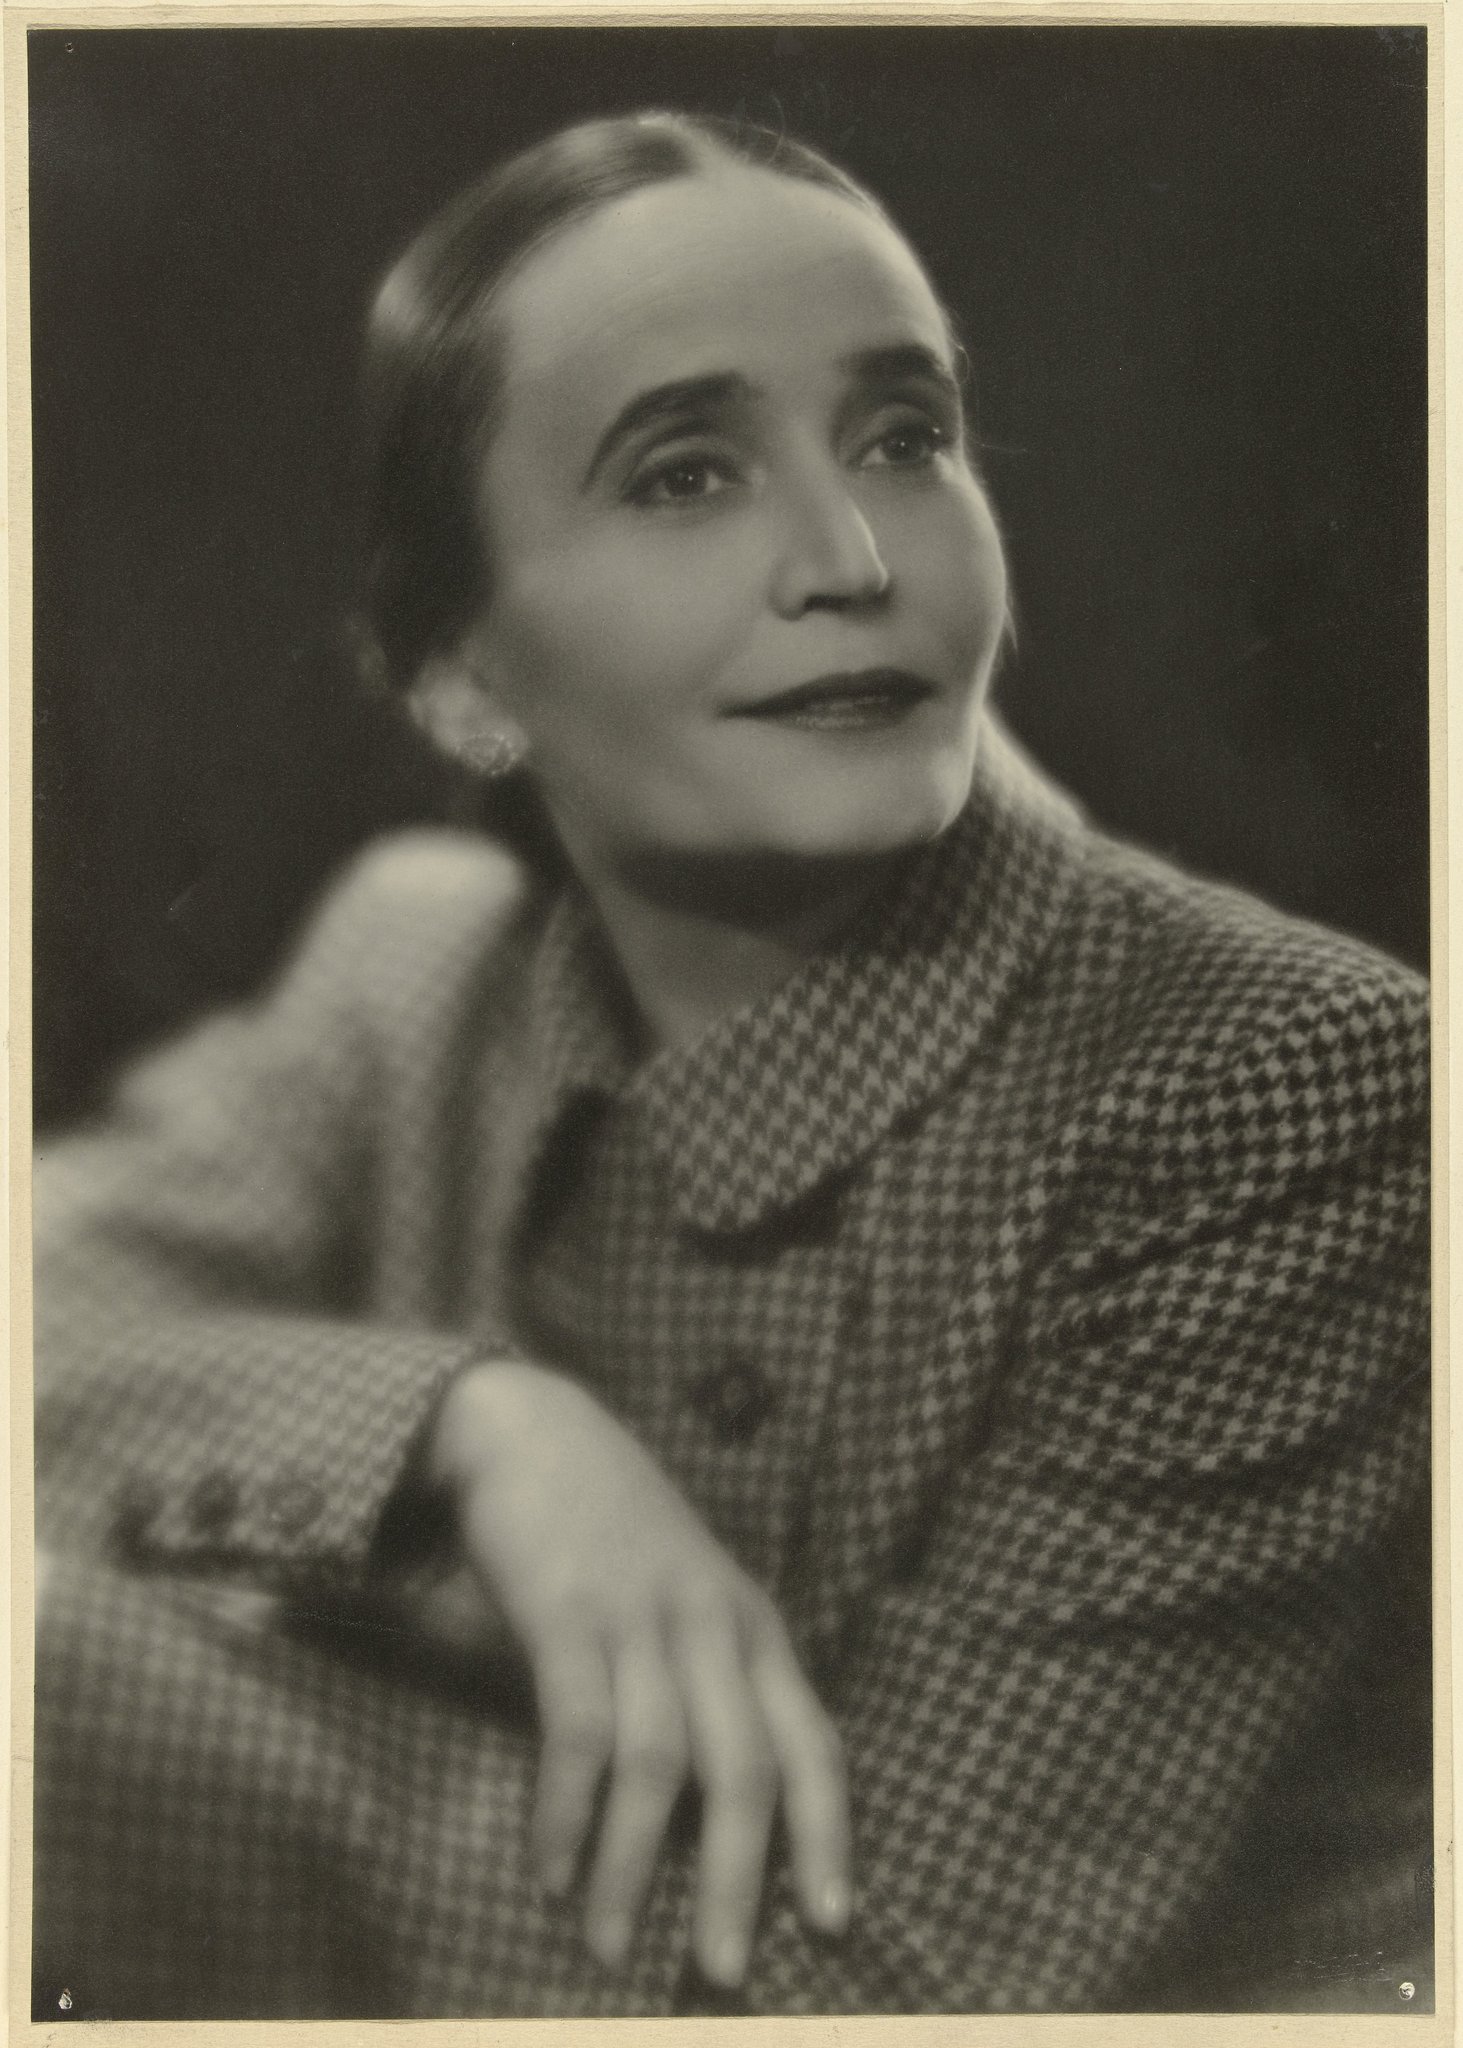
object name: photograph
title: Portret van actrice Nel Knoop in geruite mantel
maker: jacob merkelbach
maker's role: fotograaf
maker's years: 1877-1942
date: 1930-1945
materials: cardboard, photographic support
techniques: gelatin silver print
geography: amsterdam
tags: portrait of actor, actress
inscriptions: inscription: ‘Nel Knoop’